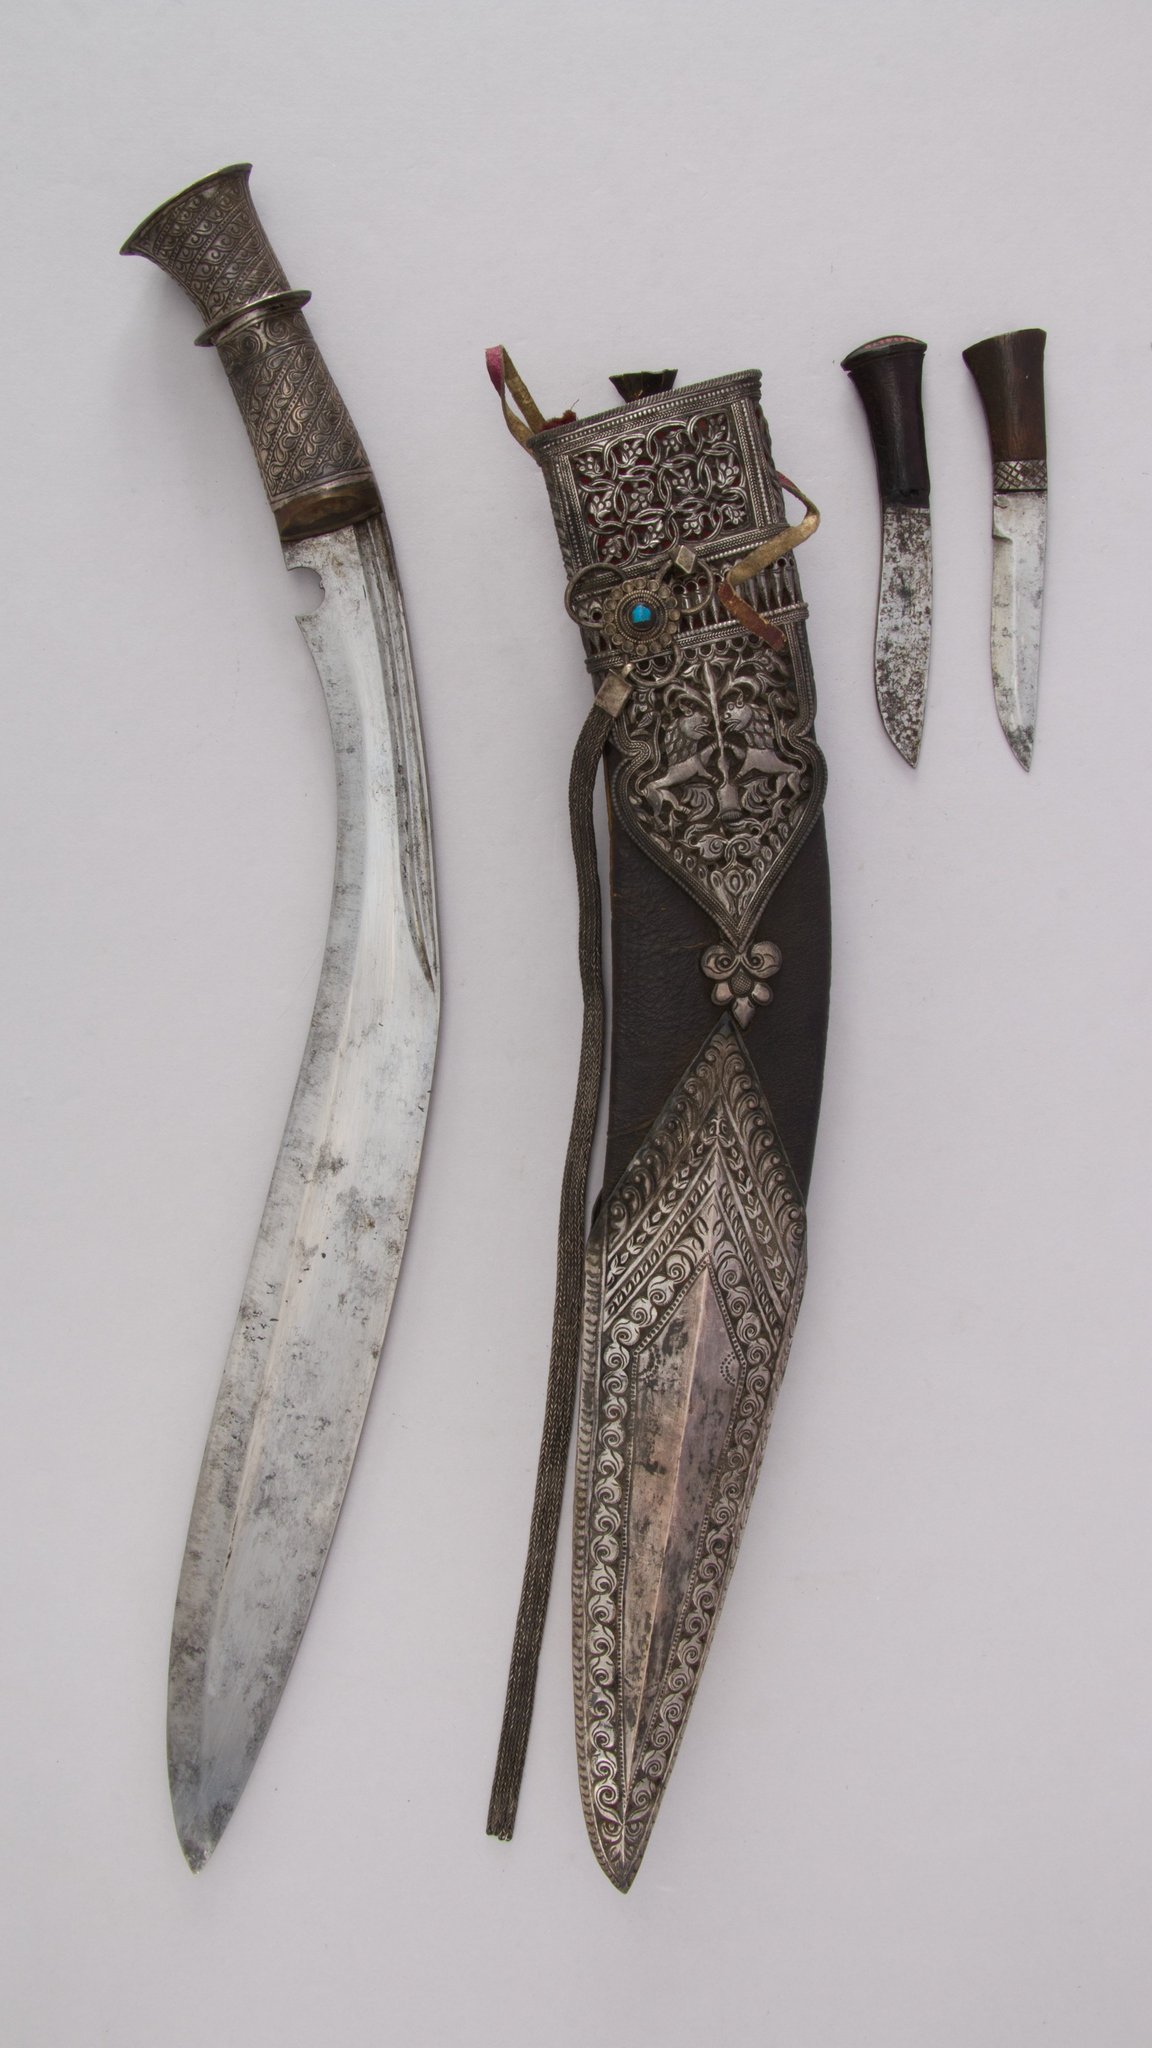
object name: knife kukri with sheath, two small knife and pouch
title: Knife (Kukri) with Sheath, Two Small Knives and Pouch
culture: gurkha or indian or nepalese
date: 1801-1900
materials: leather, silver, steel, wood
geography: india